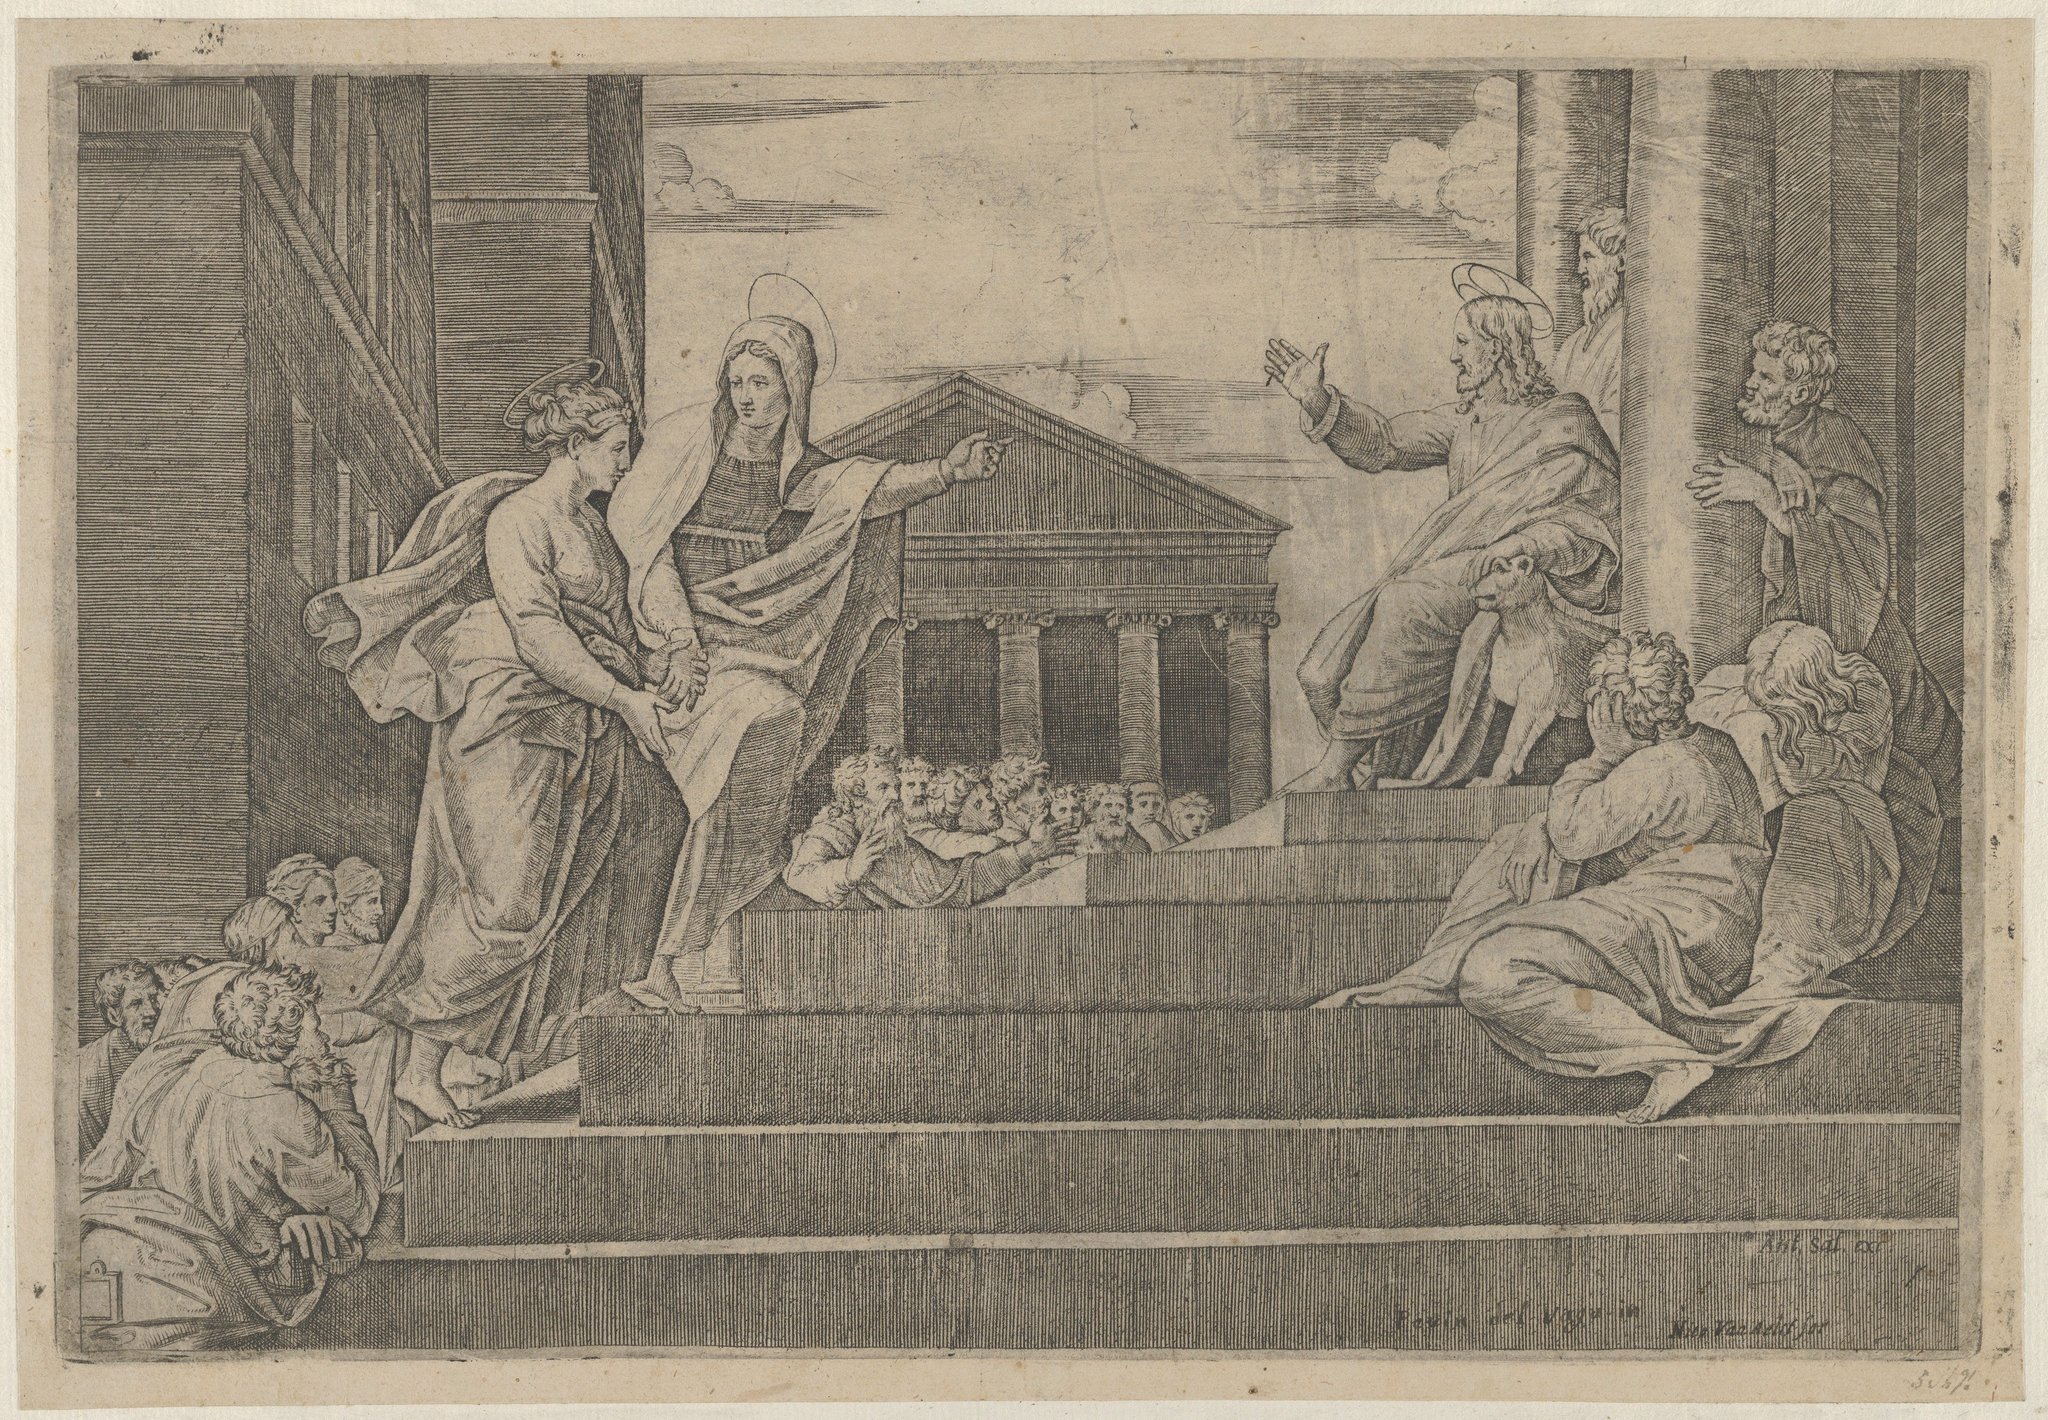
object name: print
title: Martha leading Mary Magdalene up a flight of stairs to Christ who is seated at right at the entrance to a temple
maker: marcantonio raimondi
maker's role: artist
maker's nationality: italian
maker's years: 1475-1534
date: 1520-1525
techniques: engraving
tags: temples,men,women,christ,mary magdalene